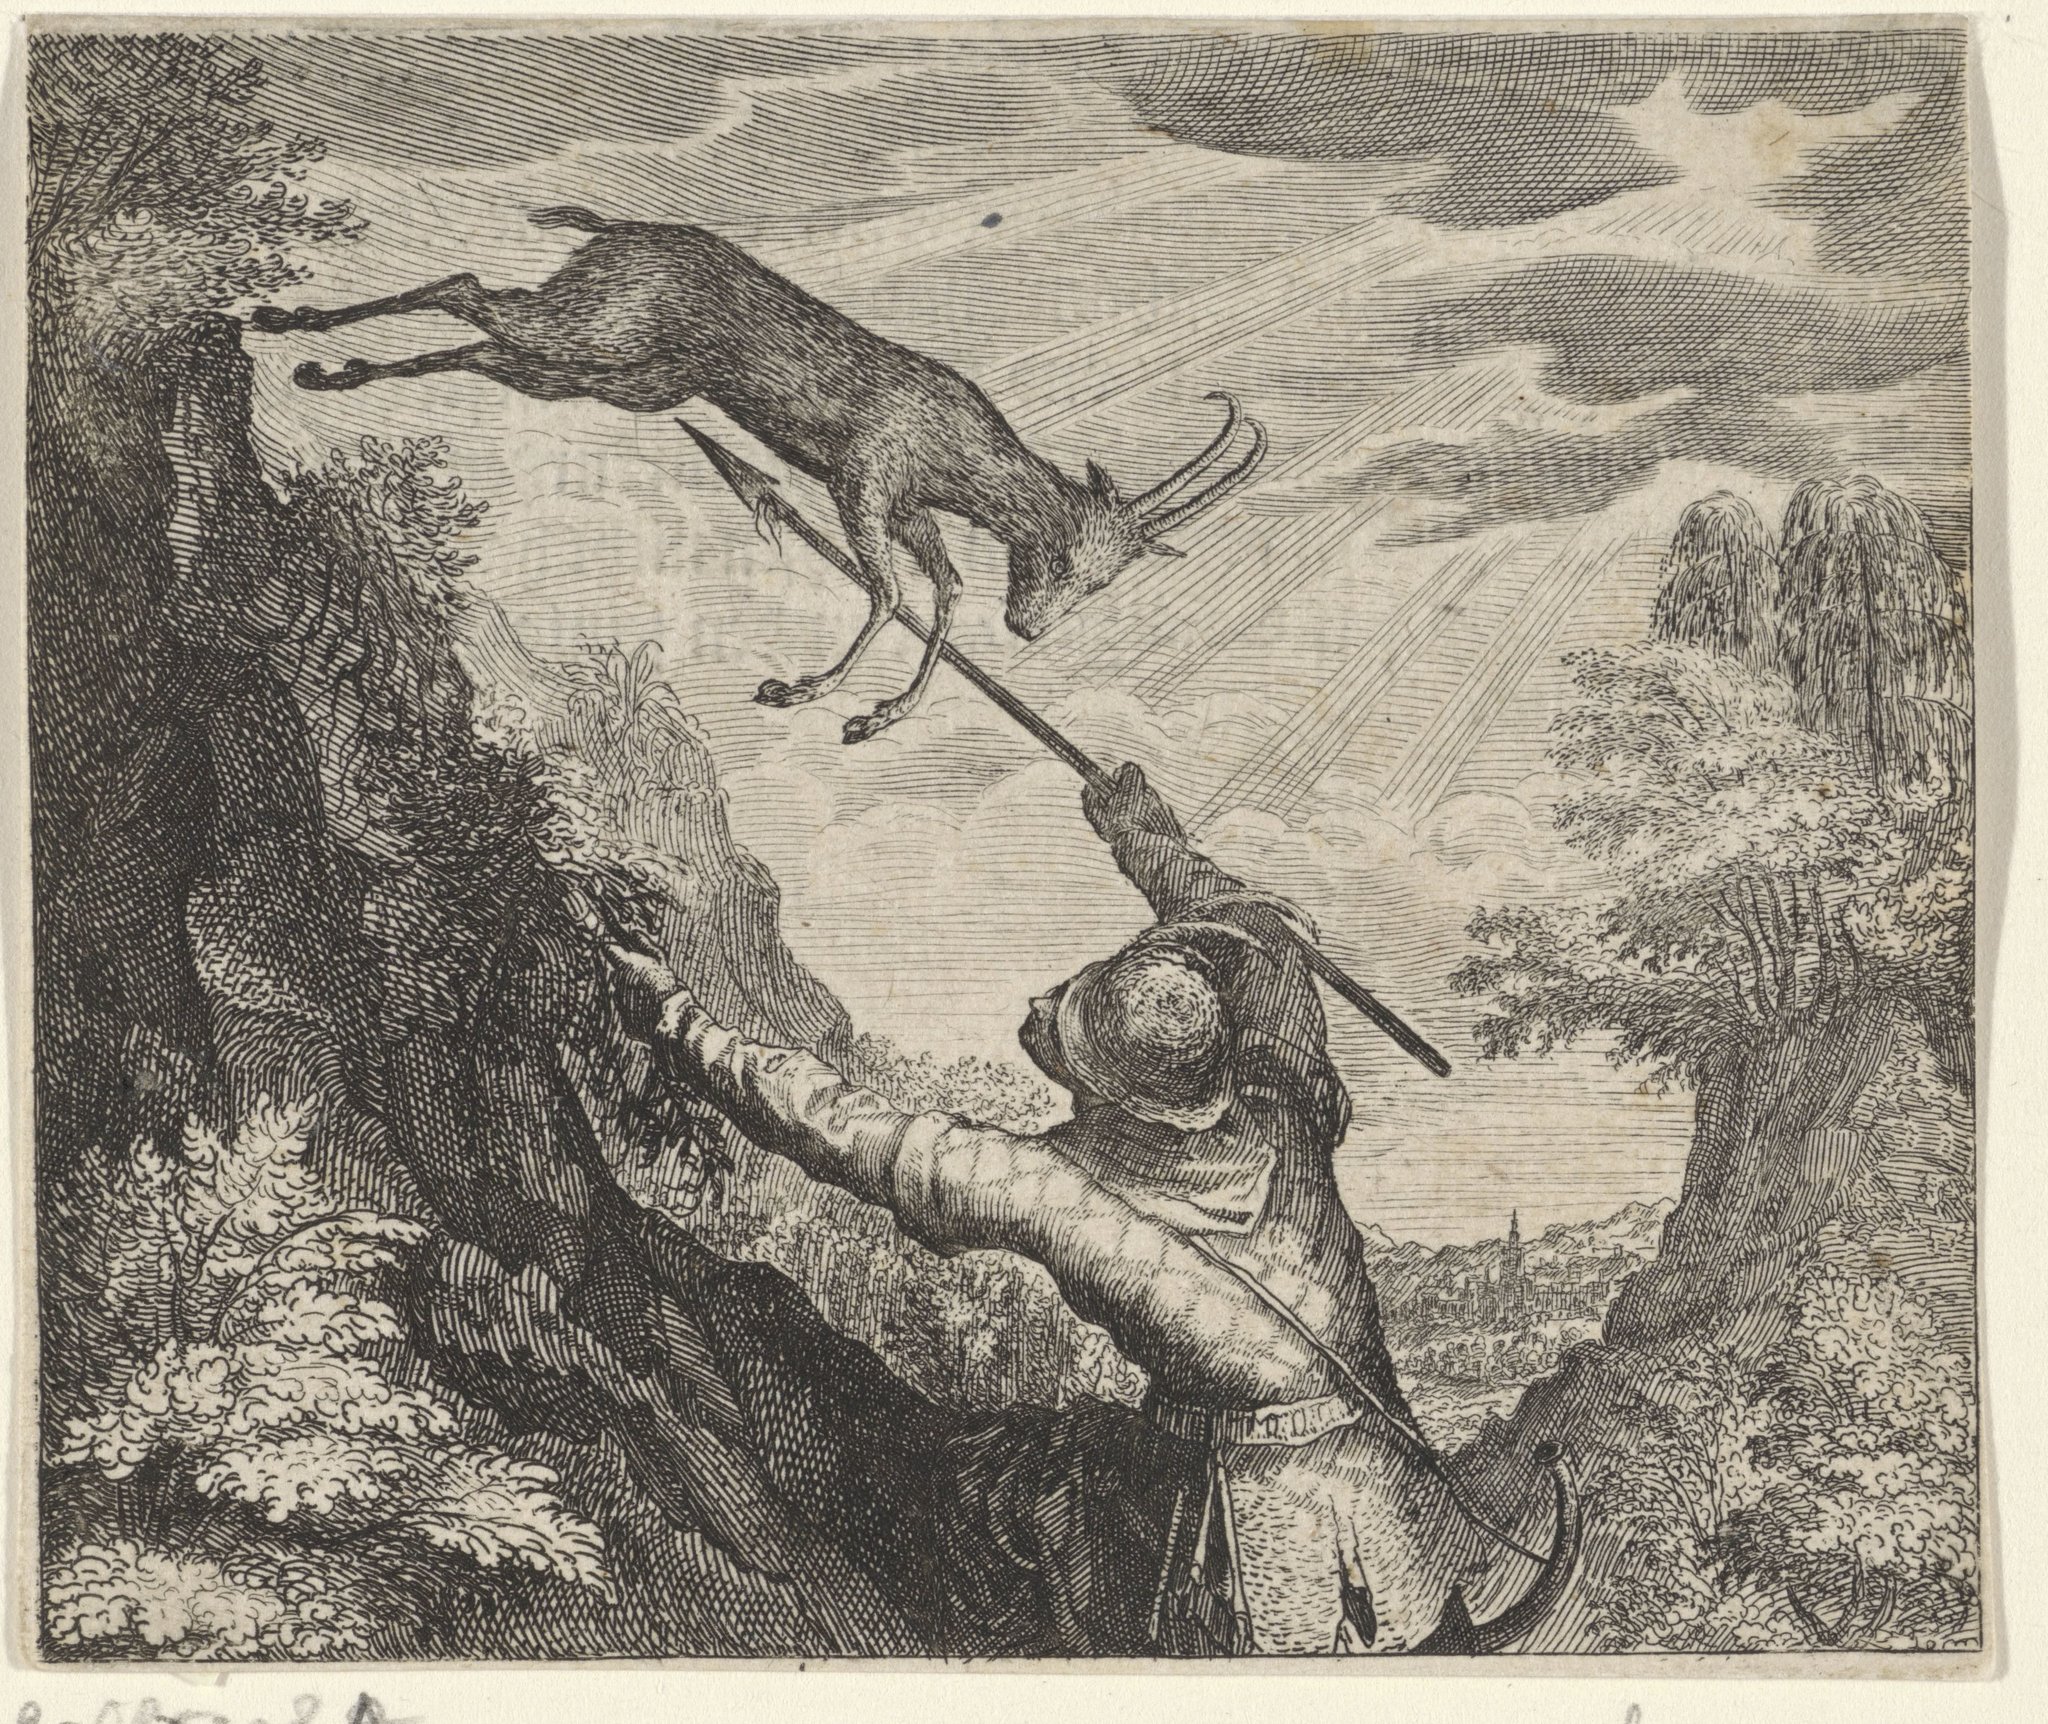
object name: book illustration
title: Fabel van de gems en de jager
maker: aegidius sadeler (ii)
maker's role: draughtsman, print maker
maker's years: 1568-1629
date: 1608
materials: paper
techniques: engraving, etching, letterpress printing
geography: prague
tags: hunter (+ spear), hoofed animals: chamois, fables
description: Een gems springt een berg af die een jager met een speer probeert te beklimmen. In de fabel van de gems en jager wordt gewaarschuwd voor overdreven doelgericht denken.